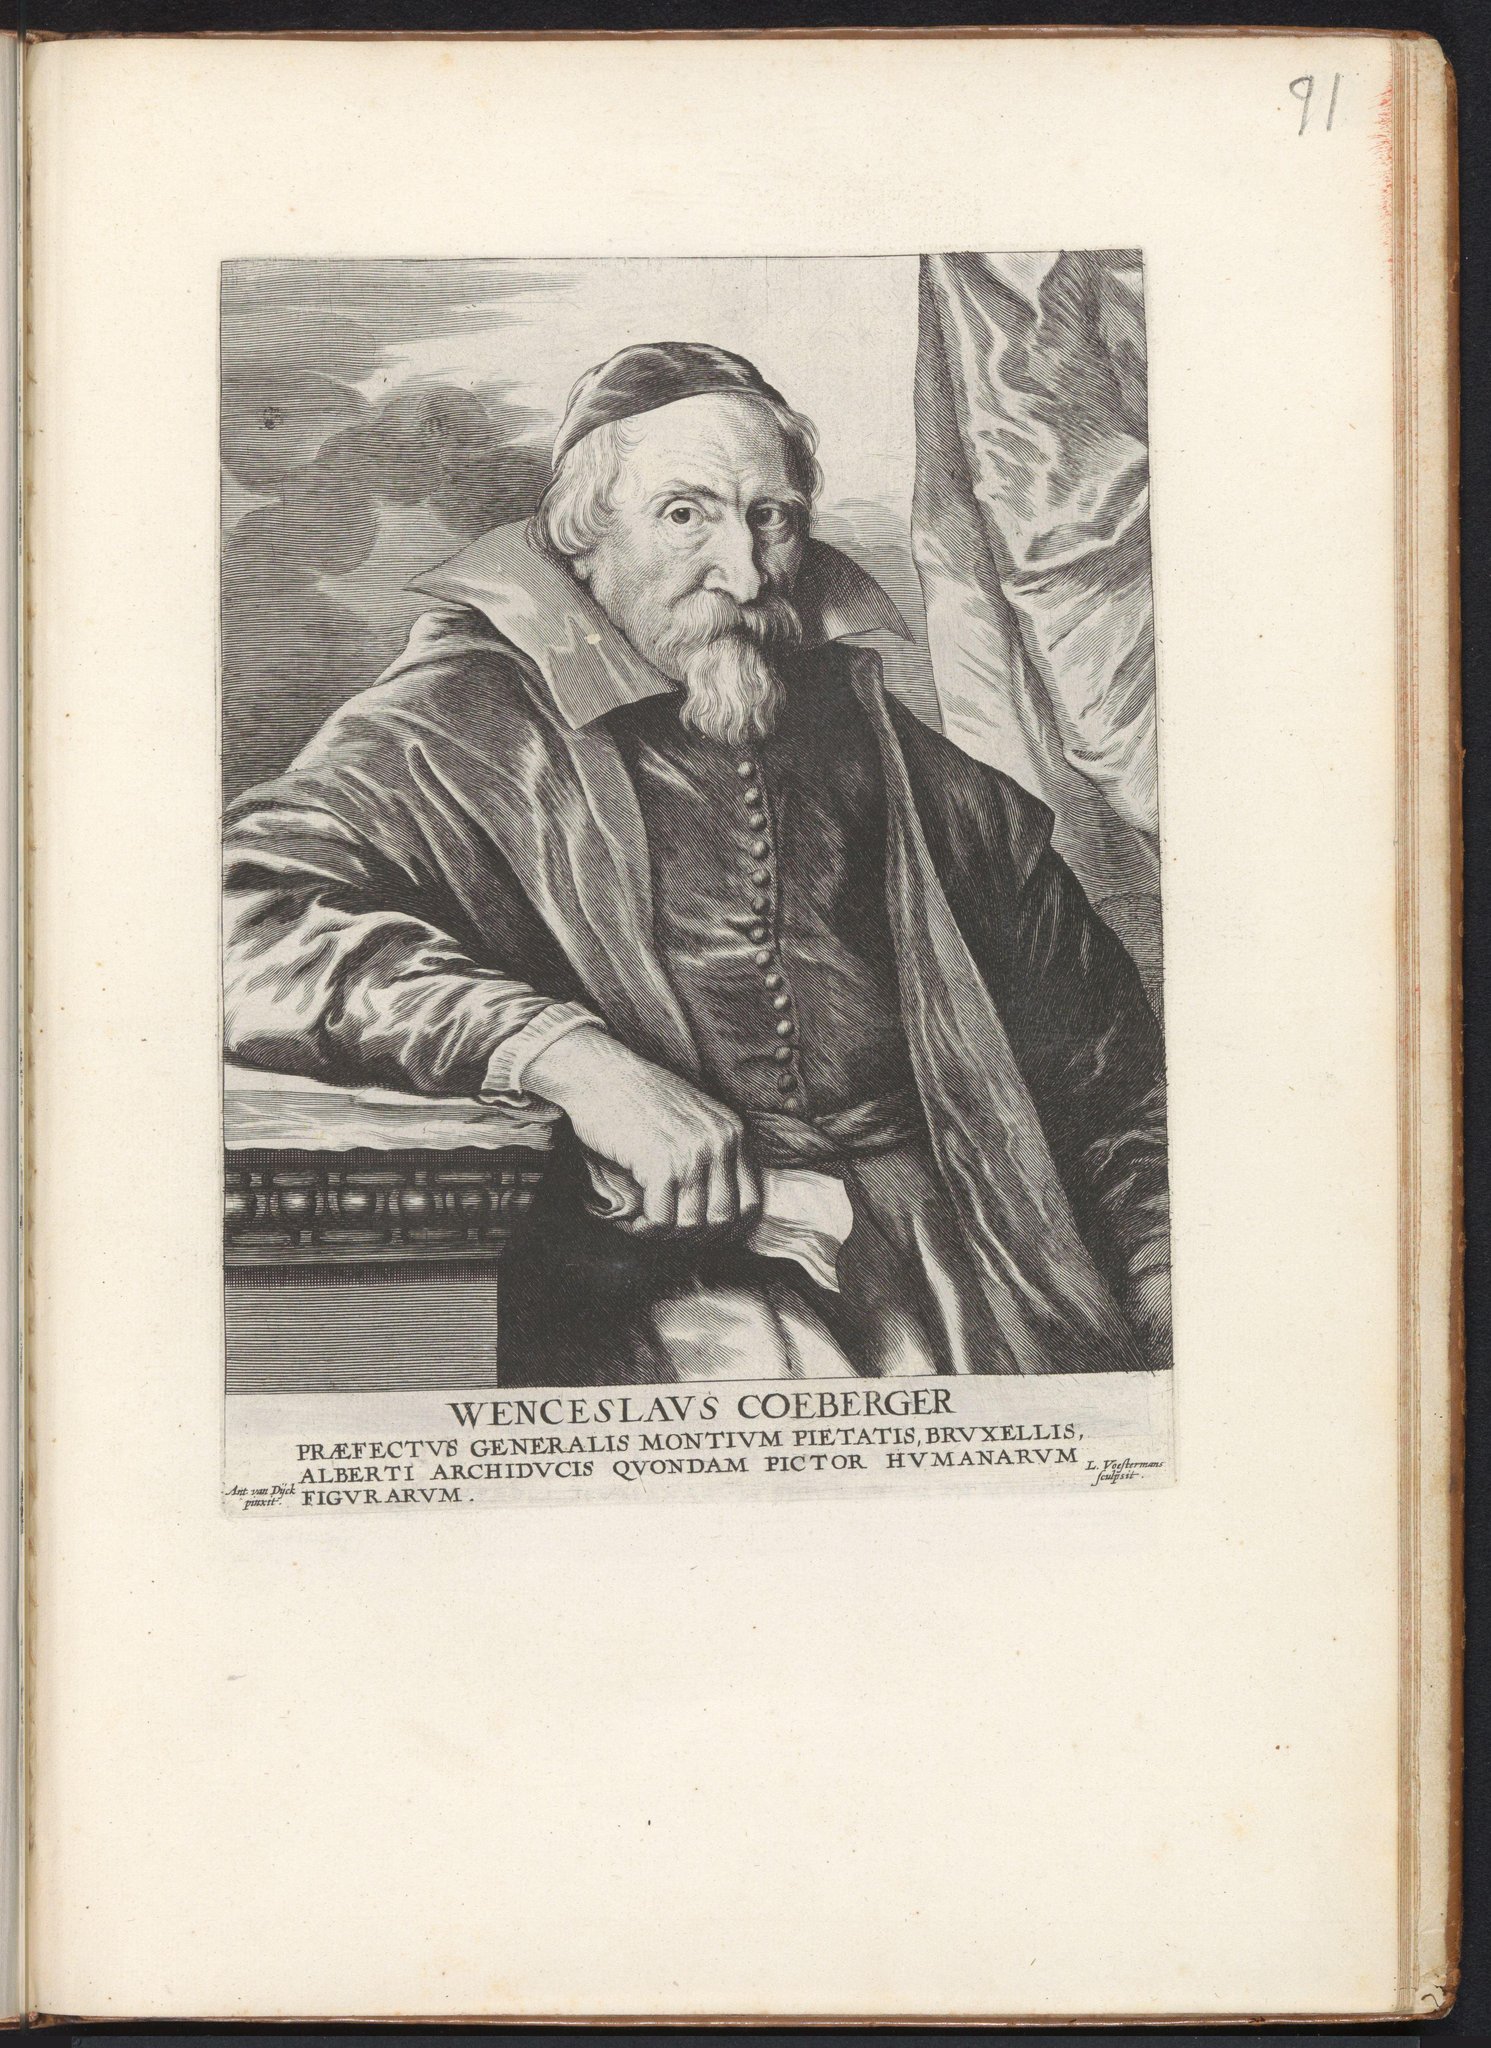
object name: print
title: Iconographie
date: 1630-1641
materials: paper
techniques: engraving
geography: antwerp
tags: painter, wenzel coebergher, portrait, self-portrait of painter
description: Deze prent maakt deel uit van een album.